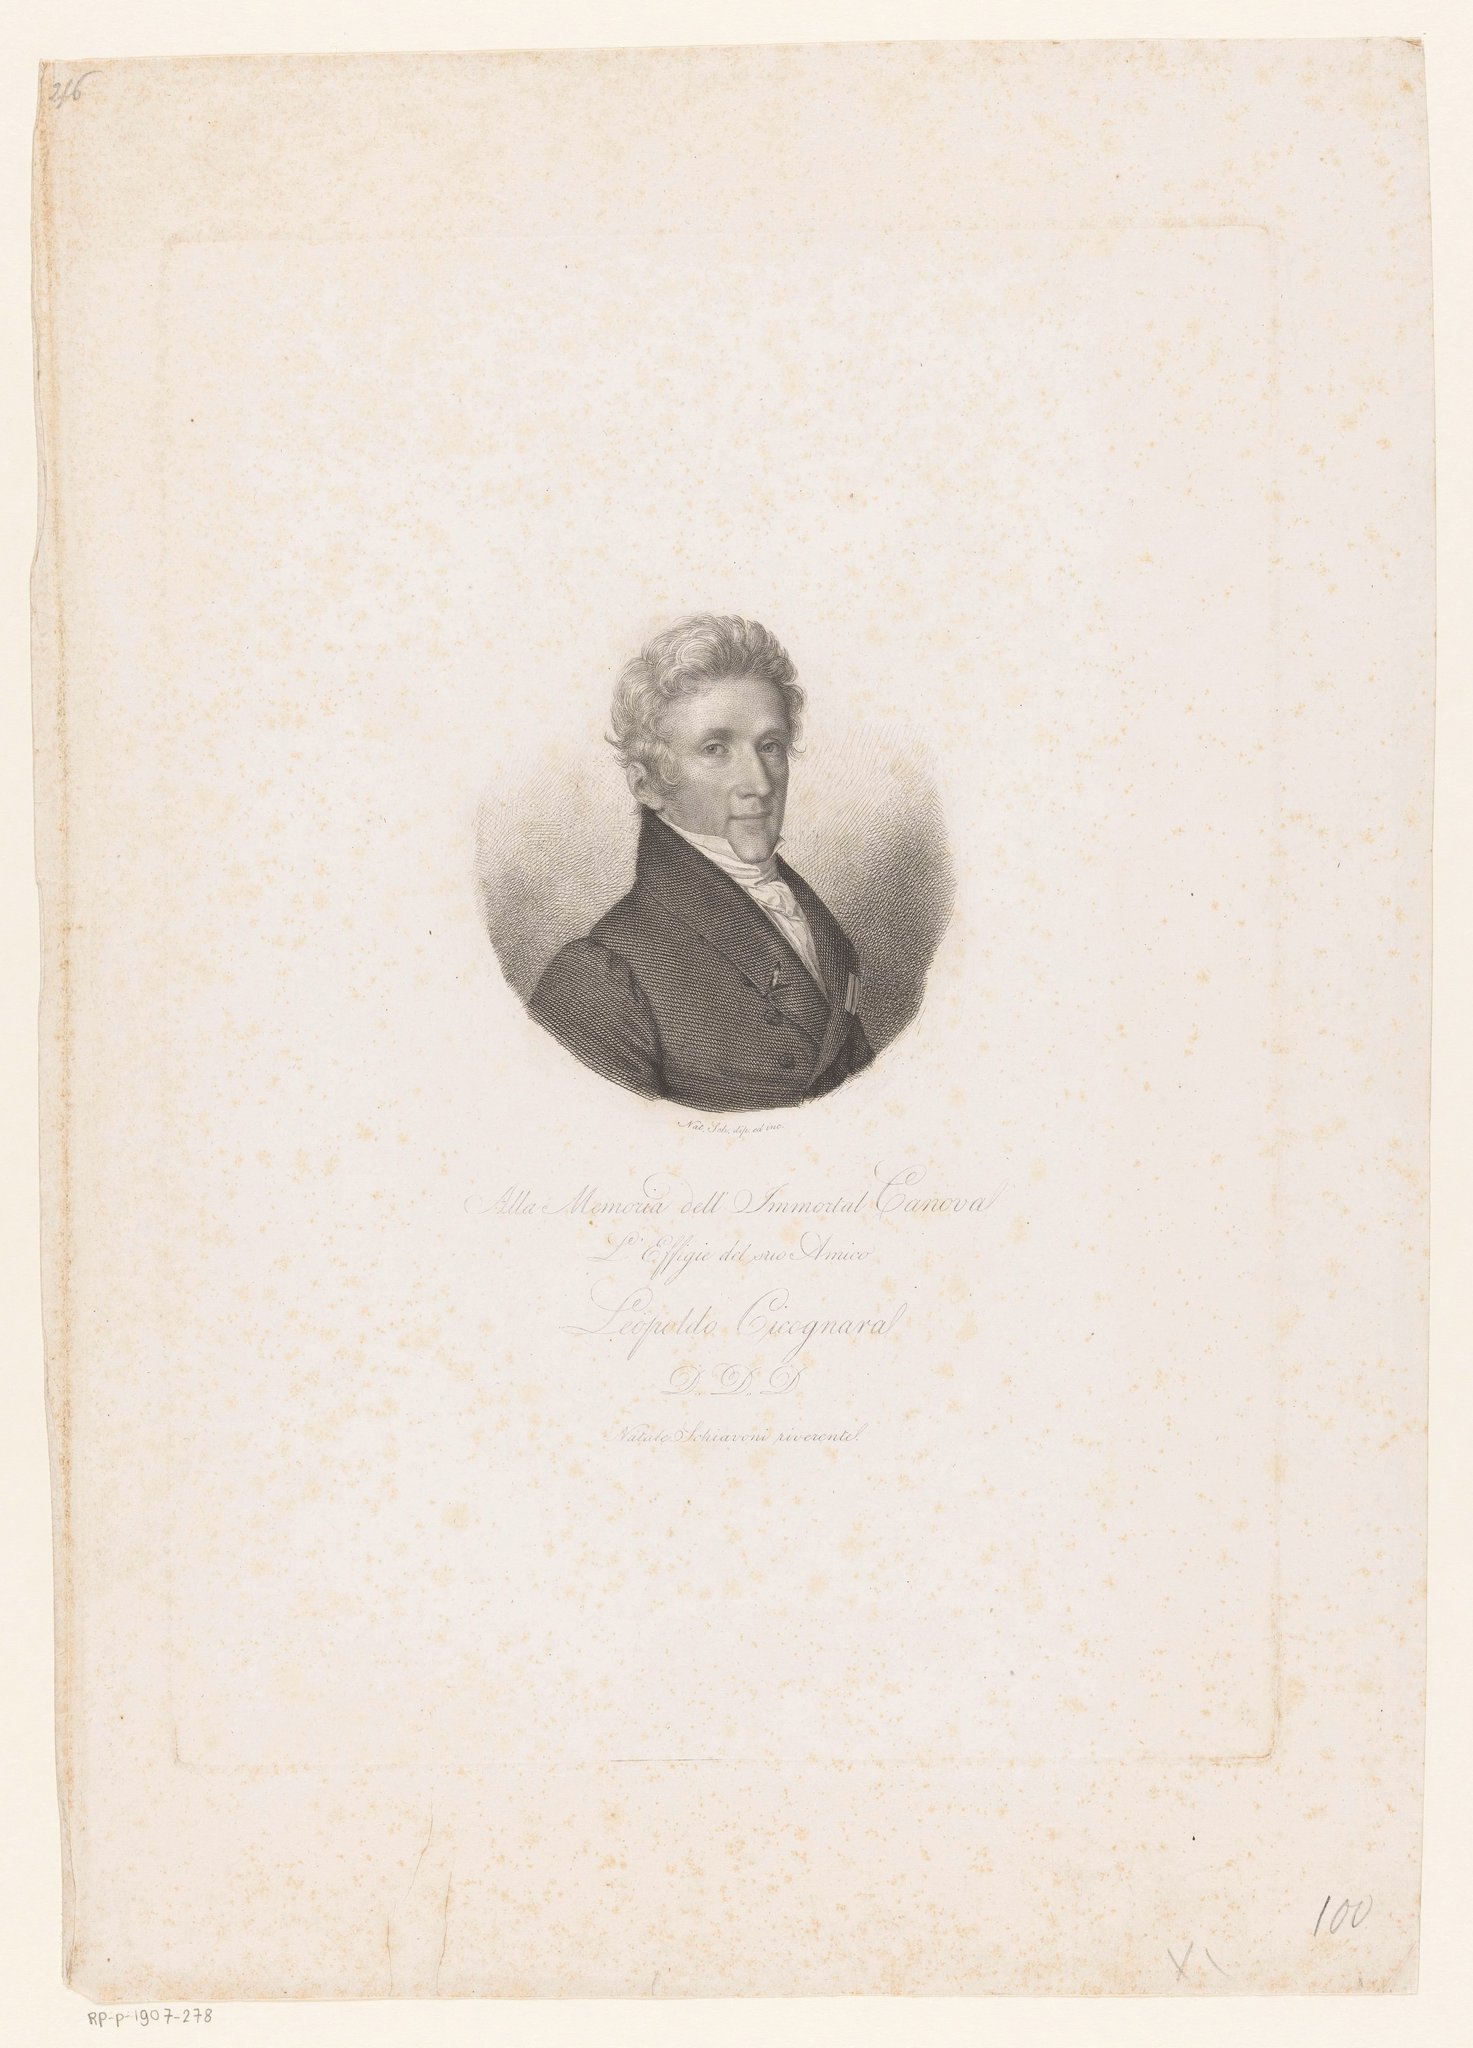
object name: print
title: Portret van kunsthistoricus Leopoldo Cicognara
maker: natale schiavoni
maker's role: draughtsman, print maker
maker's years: 1777-1858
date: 1822-1858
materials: paper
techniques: etching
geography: italy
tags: venice, leopoldo cicognara, historical persons, portrait, self-portrait of artist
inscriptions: collector's mark: Lugt 2228